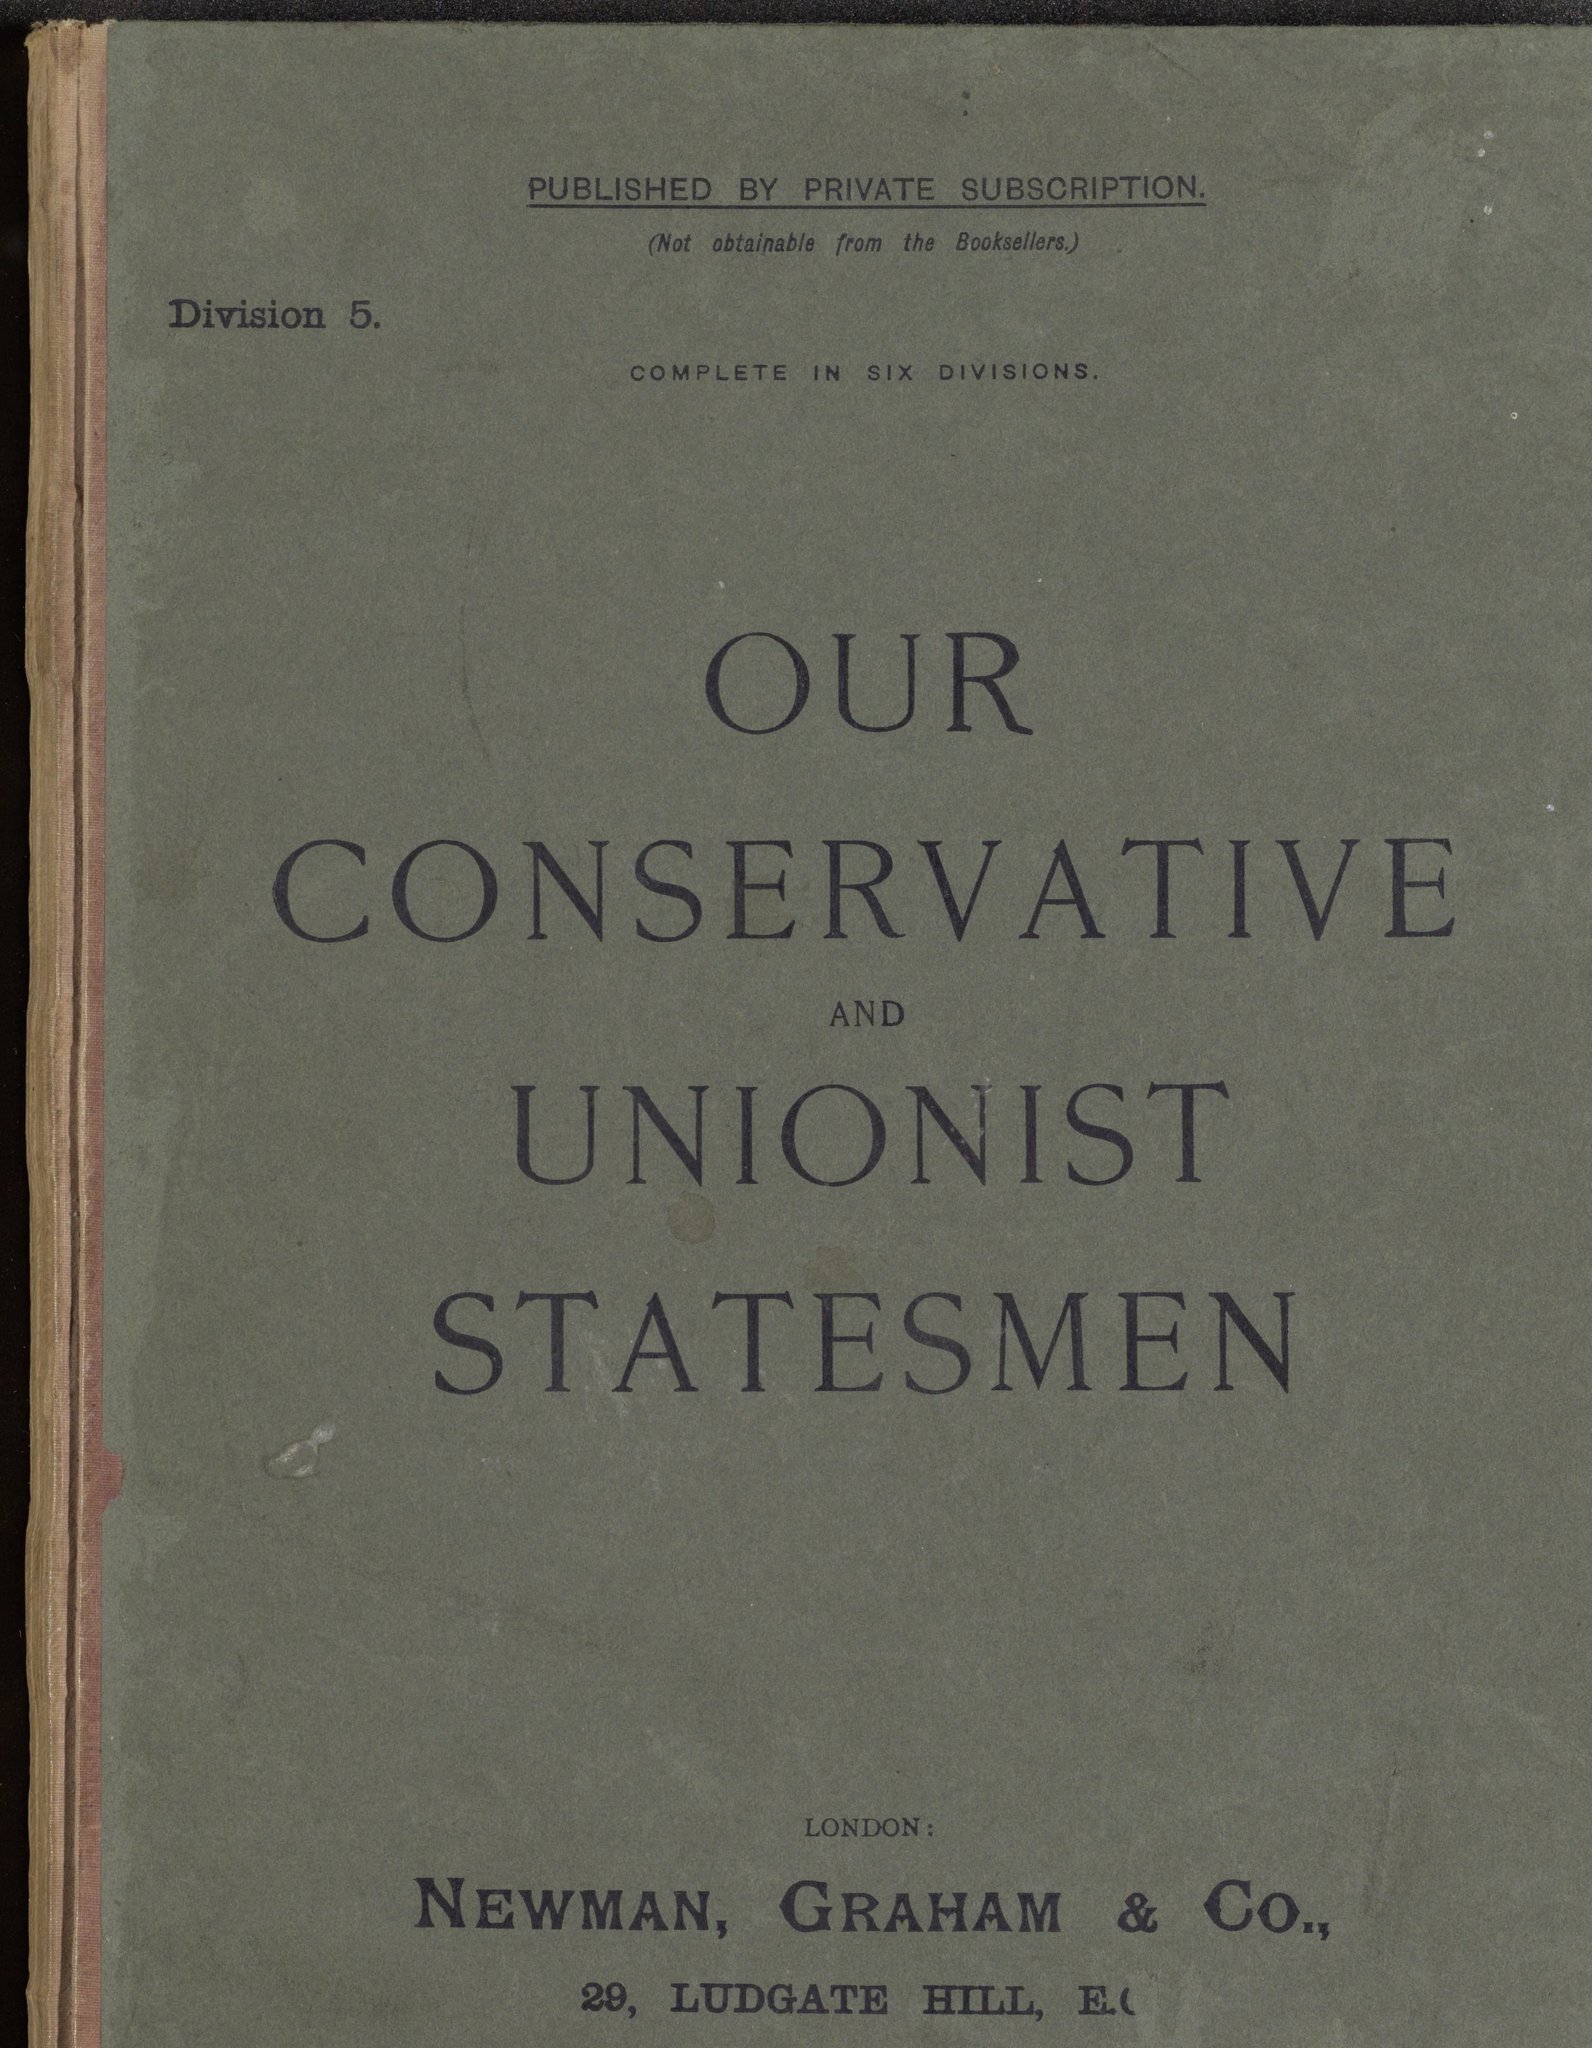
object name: book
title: Our conservative and unionist statesmen division 5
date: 1900-1903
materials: cardboard, paper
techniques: carbon print, printing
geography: london